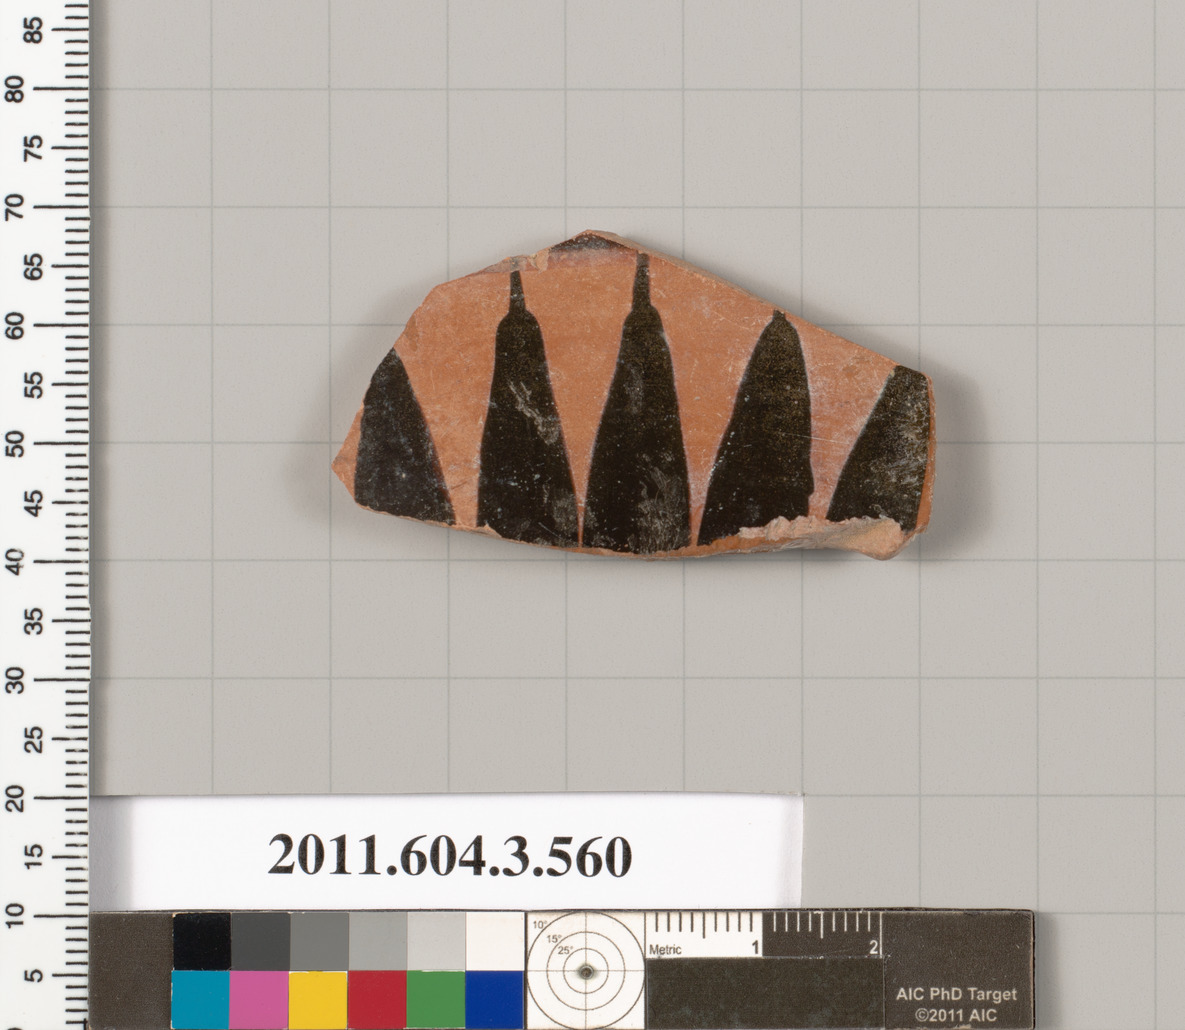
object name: column krater fragment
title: Terracotta fragment of a column-krater (bowl for mixing wine and water)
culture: greek, attic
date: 600-401 BCE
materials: terracotta